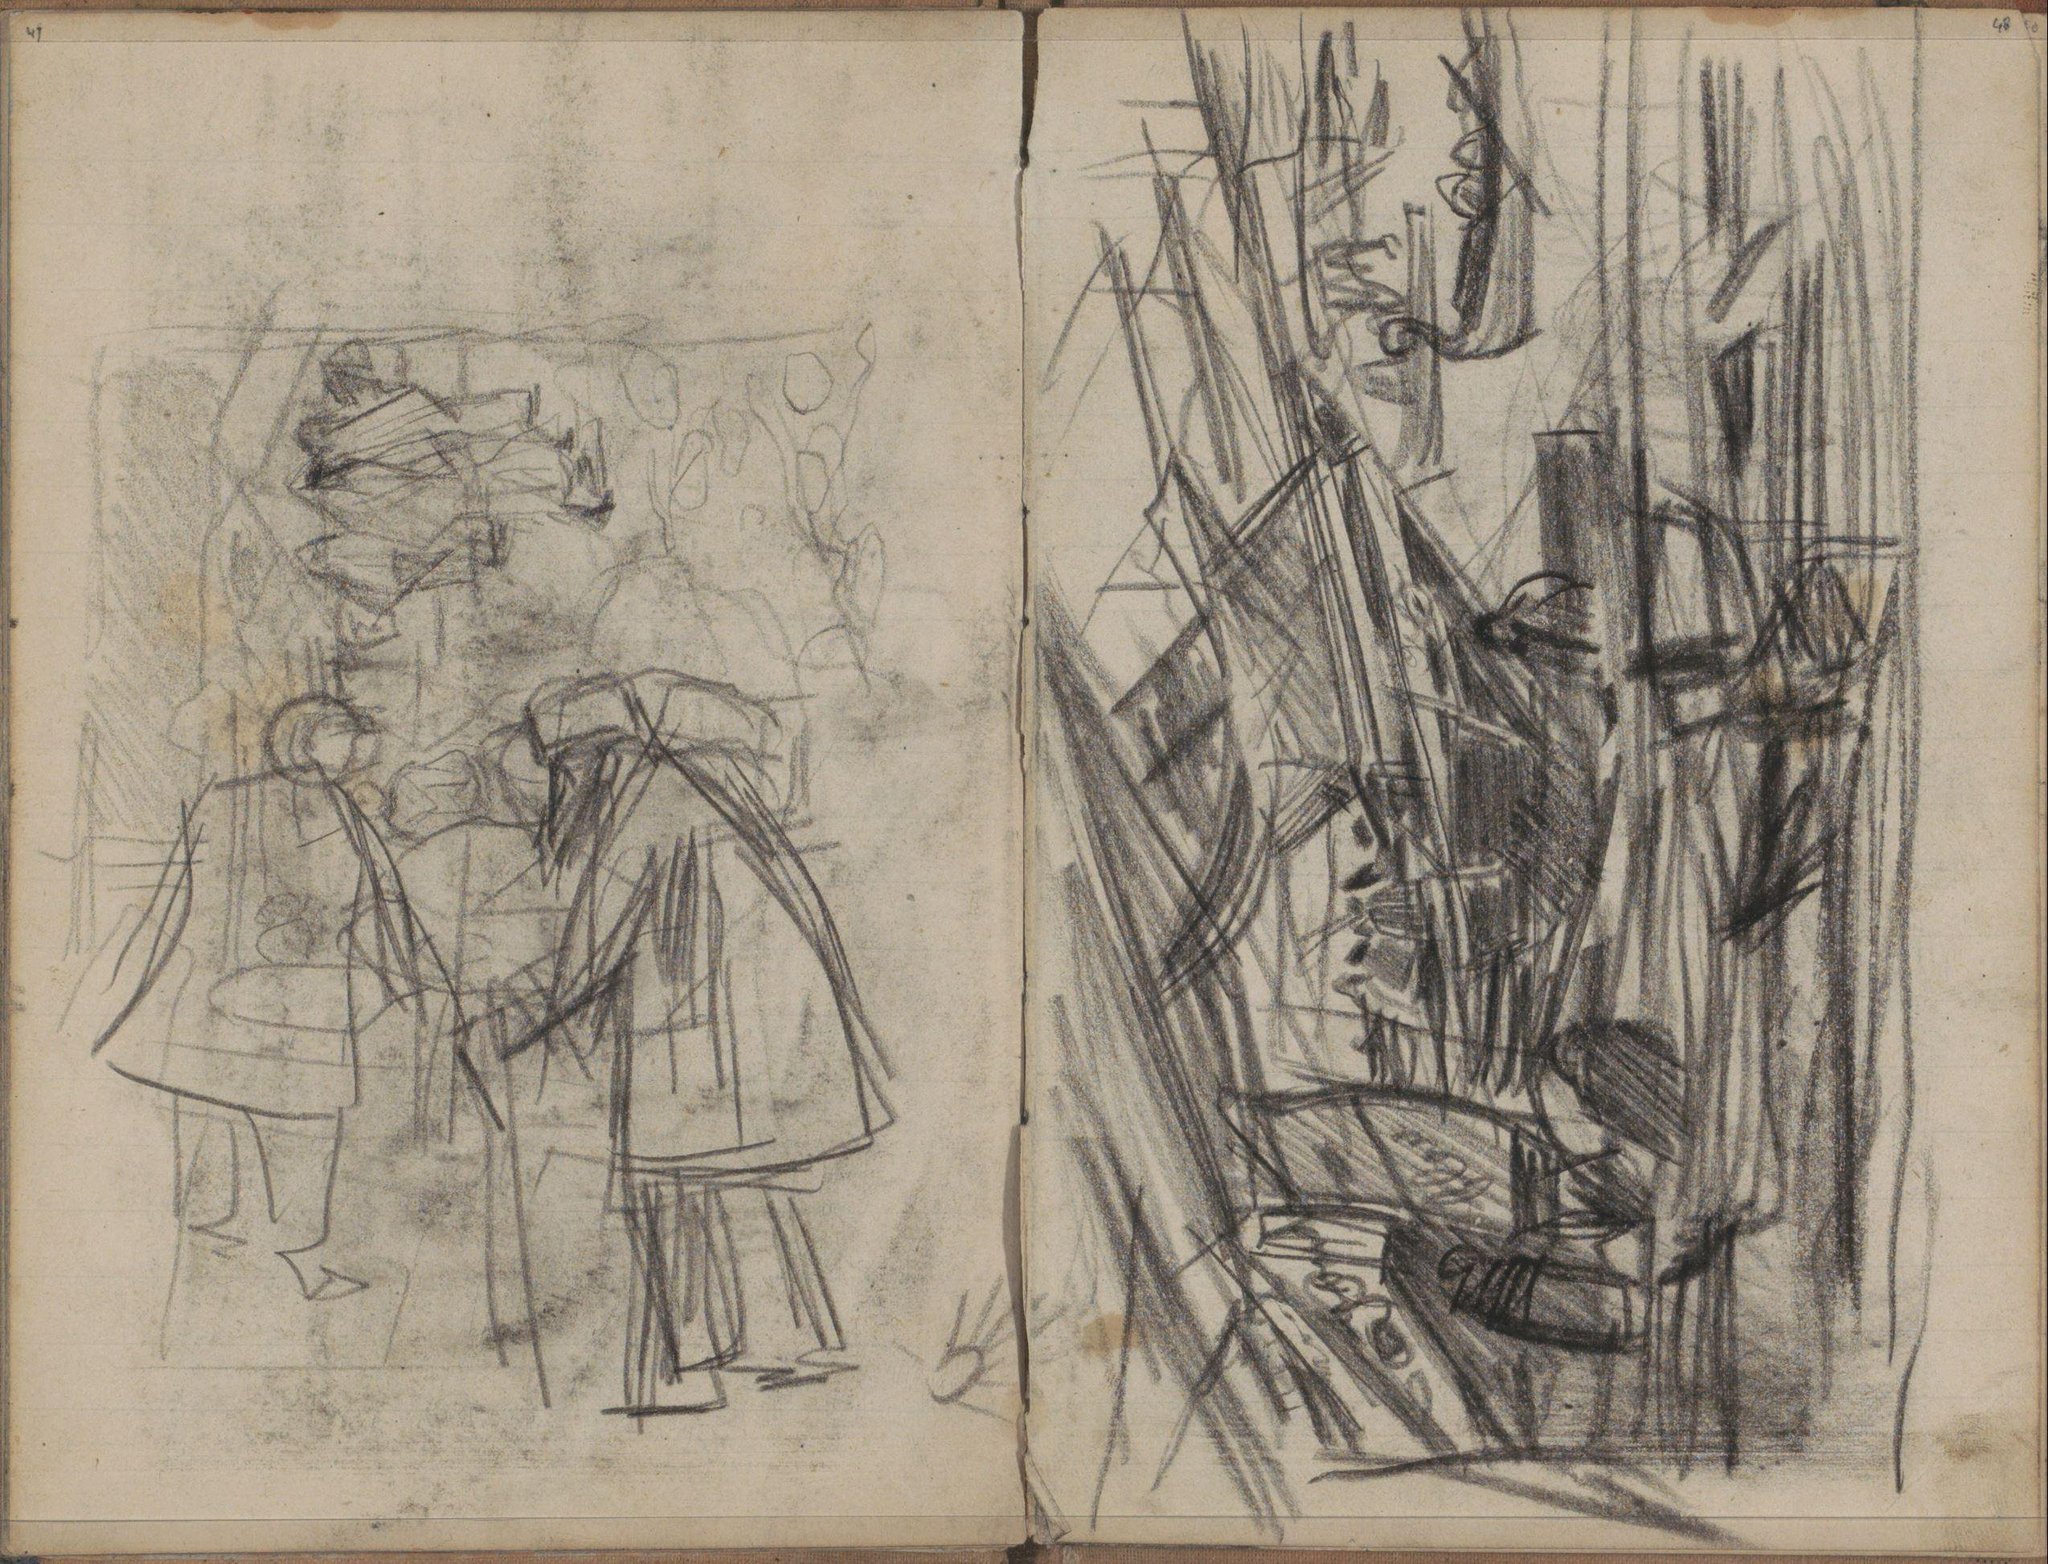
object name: sketchbook leaf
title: Roeiboten op het water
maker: marius bauer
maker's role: draughtsman, print maker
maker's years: 1867-1932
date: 1888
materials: chalk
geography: istanbul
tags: rowing-boat, canoe, etc.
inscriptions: kleurnotitie, handgeschreven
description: Mogelijk varen de boten op de Bosporus. Pagina 48 uit een schetsboek met 58 bladen.